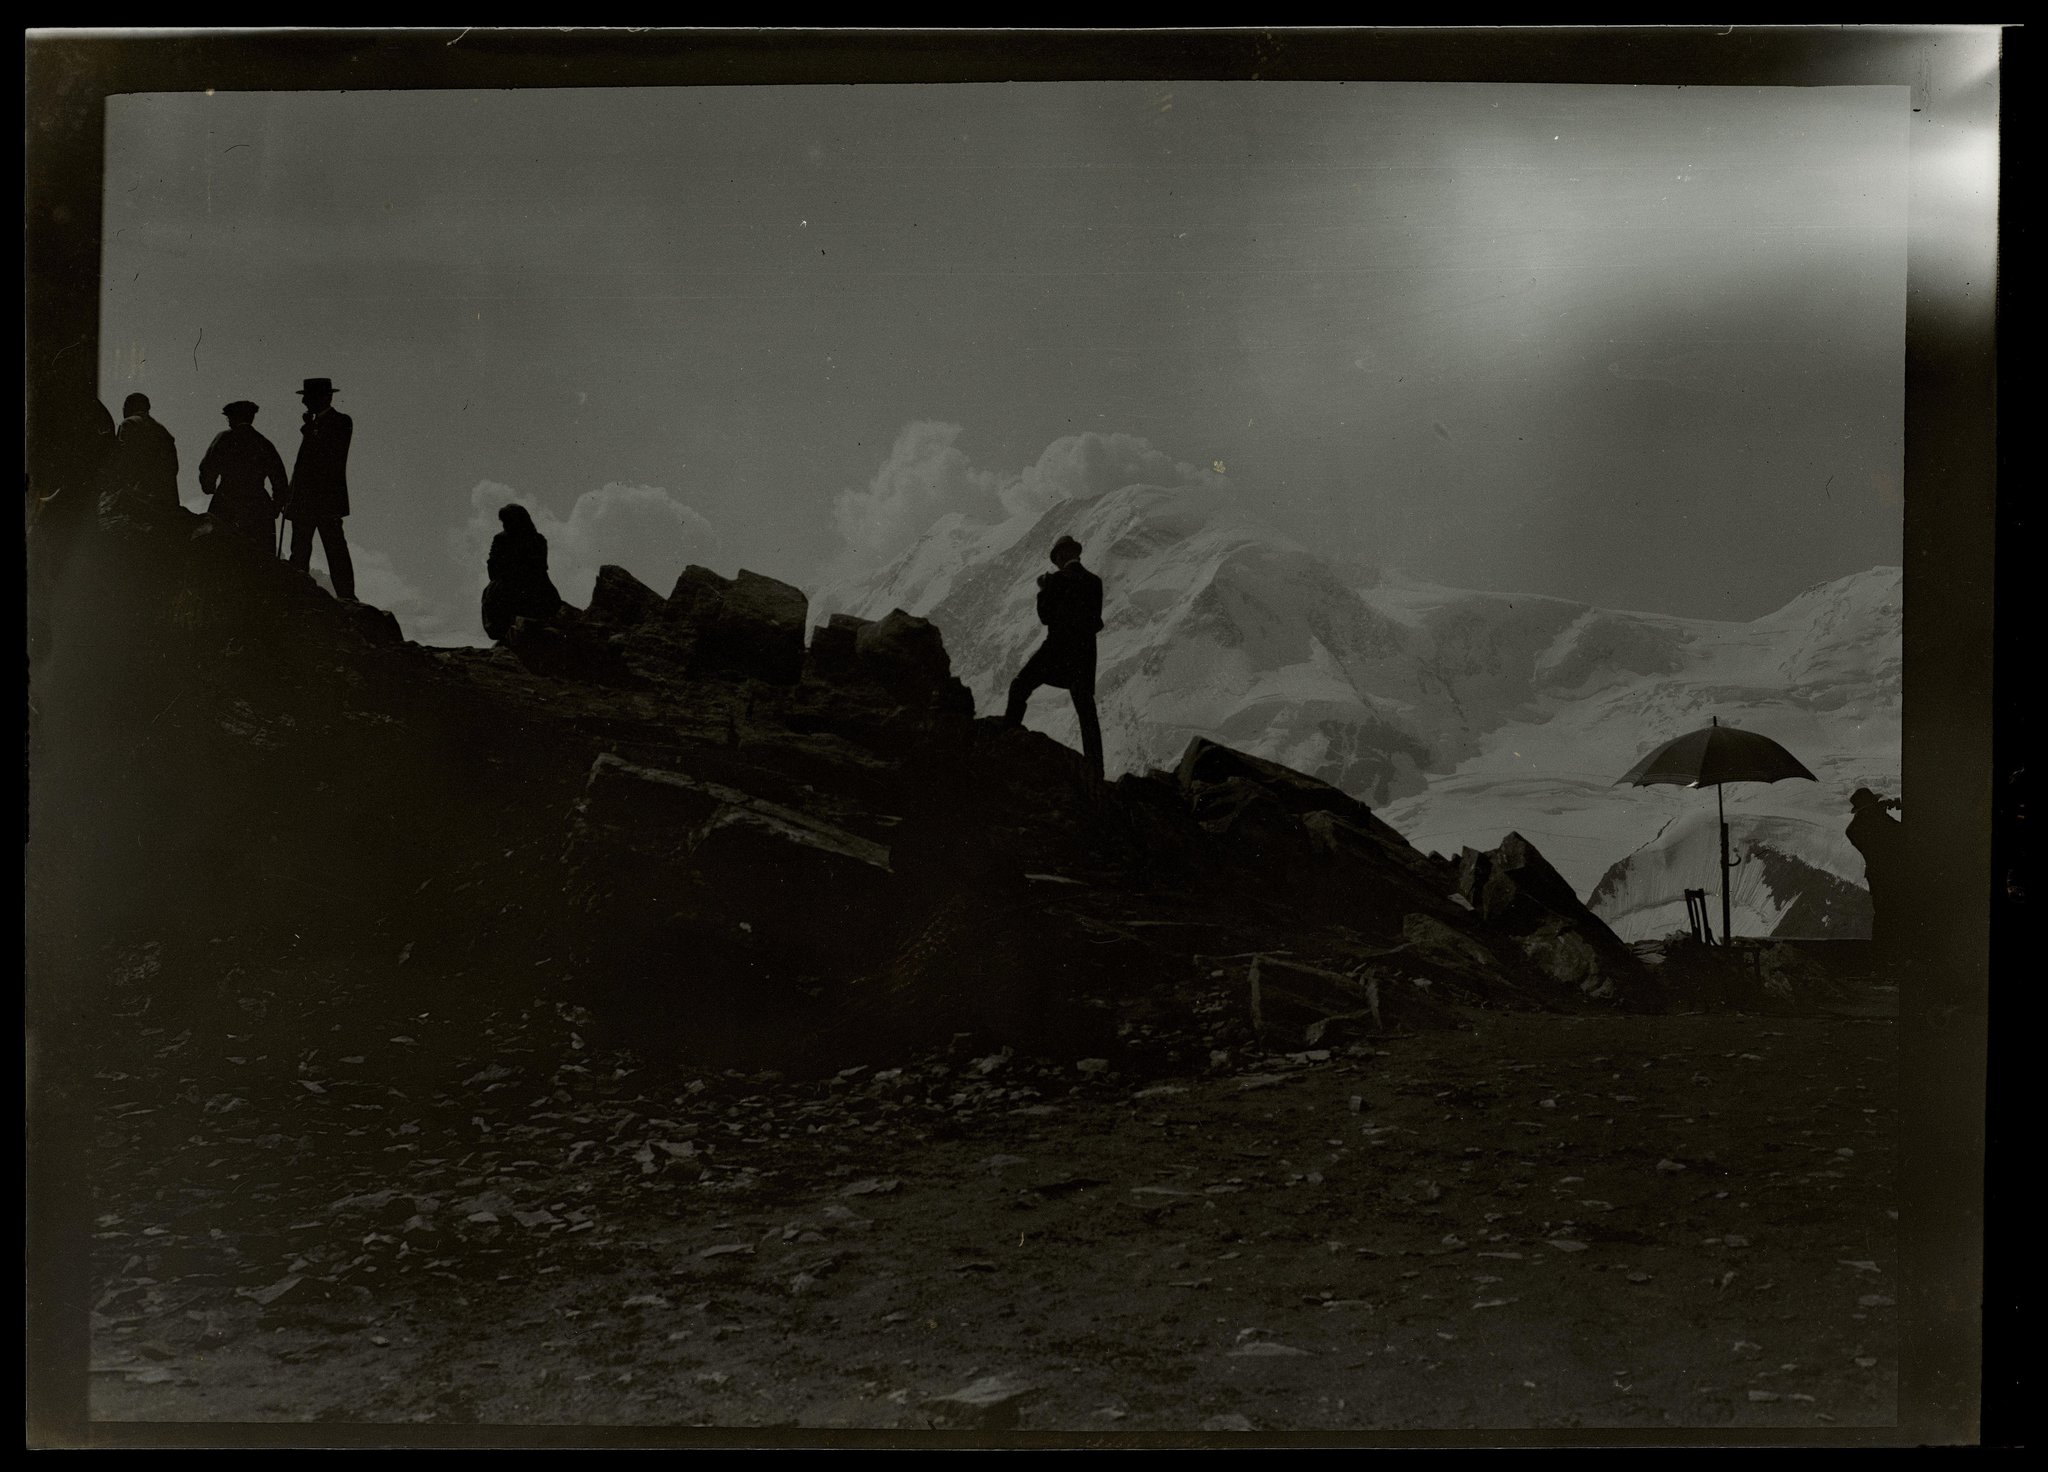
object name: photograph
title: Filmnegatief met opname van Zermatt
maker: Anonymous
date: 1921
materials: film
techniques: gelatin silver negative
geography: zermatt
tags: zermatt